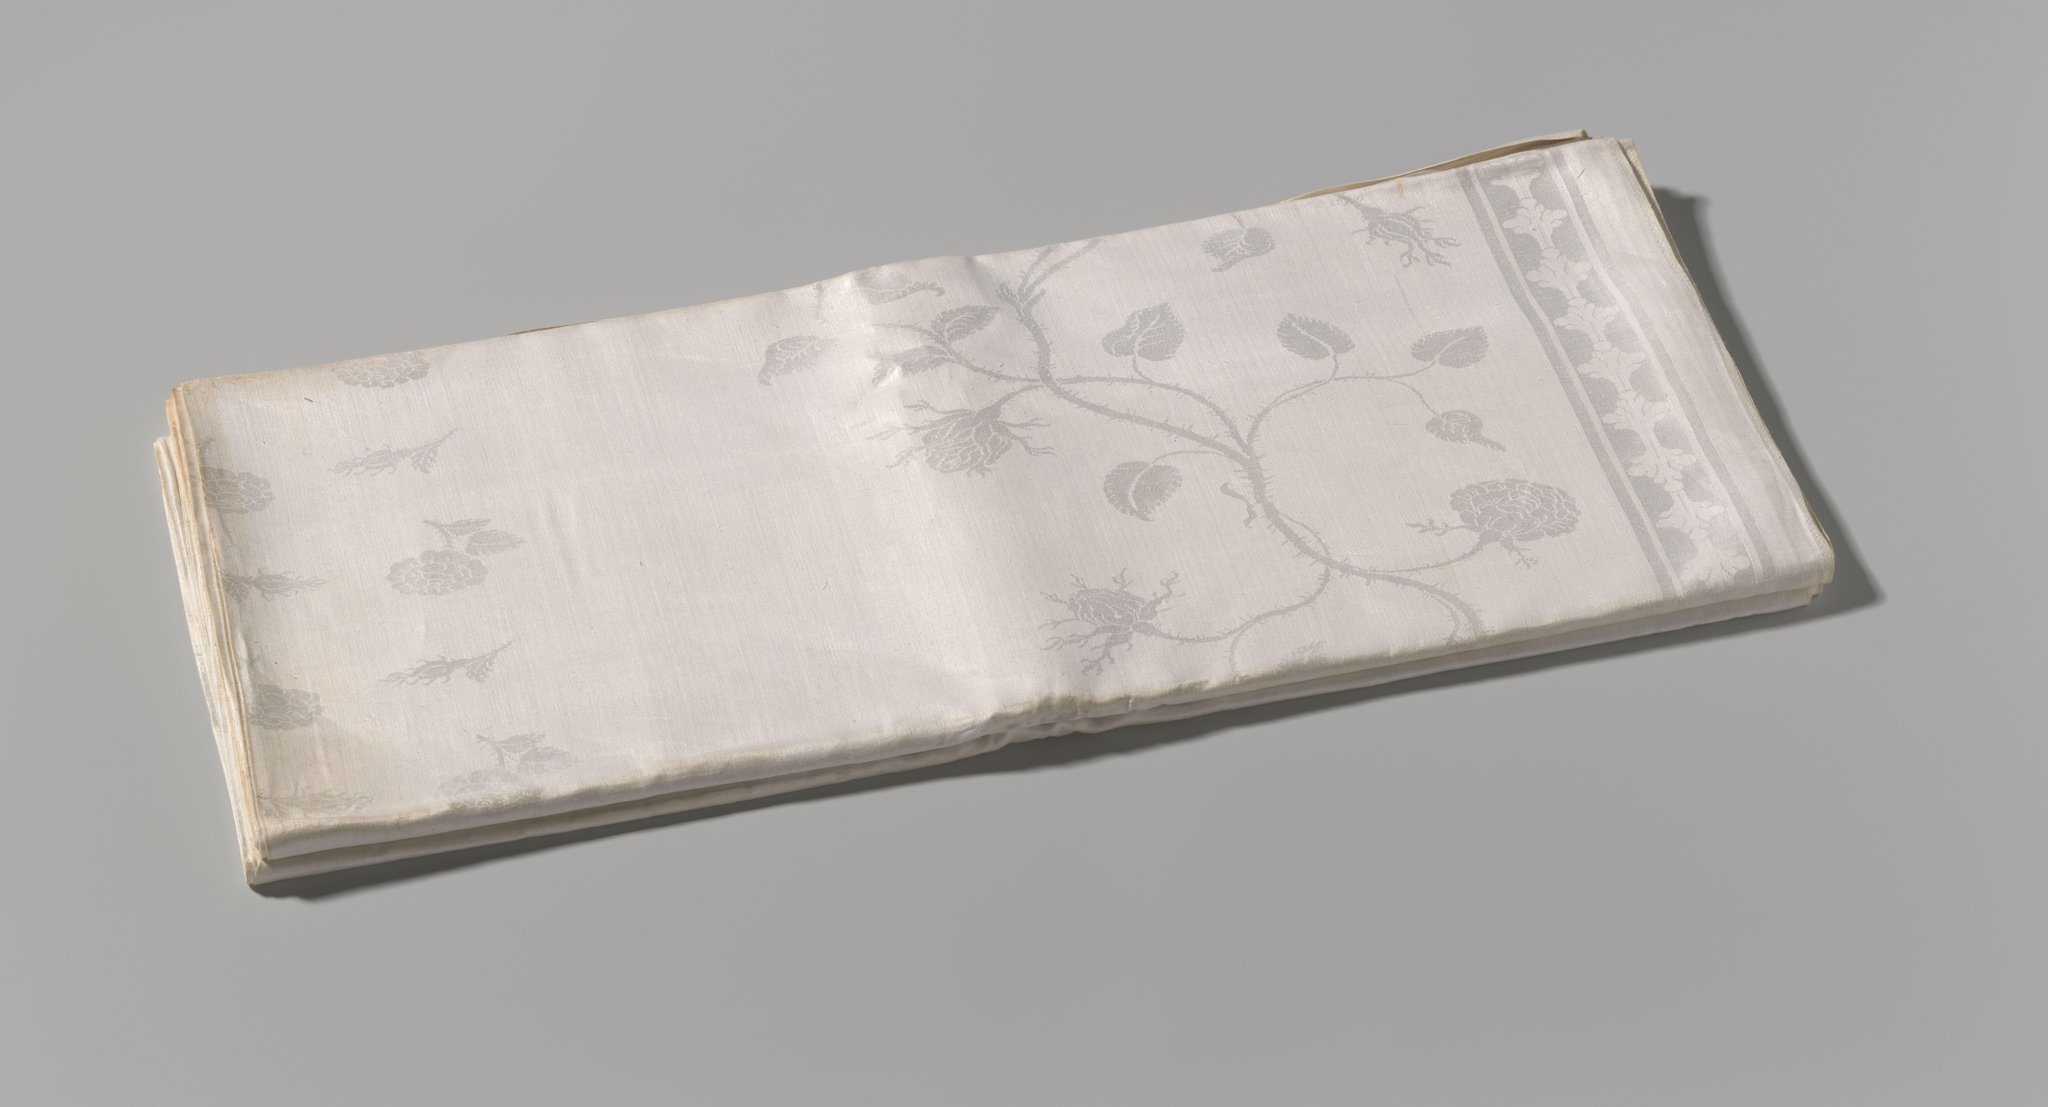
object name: tablecloth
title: Tafellaken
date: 1776-1799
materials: linen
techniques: damask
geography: germany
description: Wit linnen damasten tafellaken met een patroon van gestrooide rozetakjes met een rand van rozentakken. Merk BSG 2.